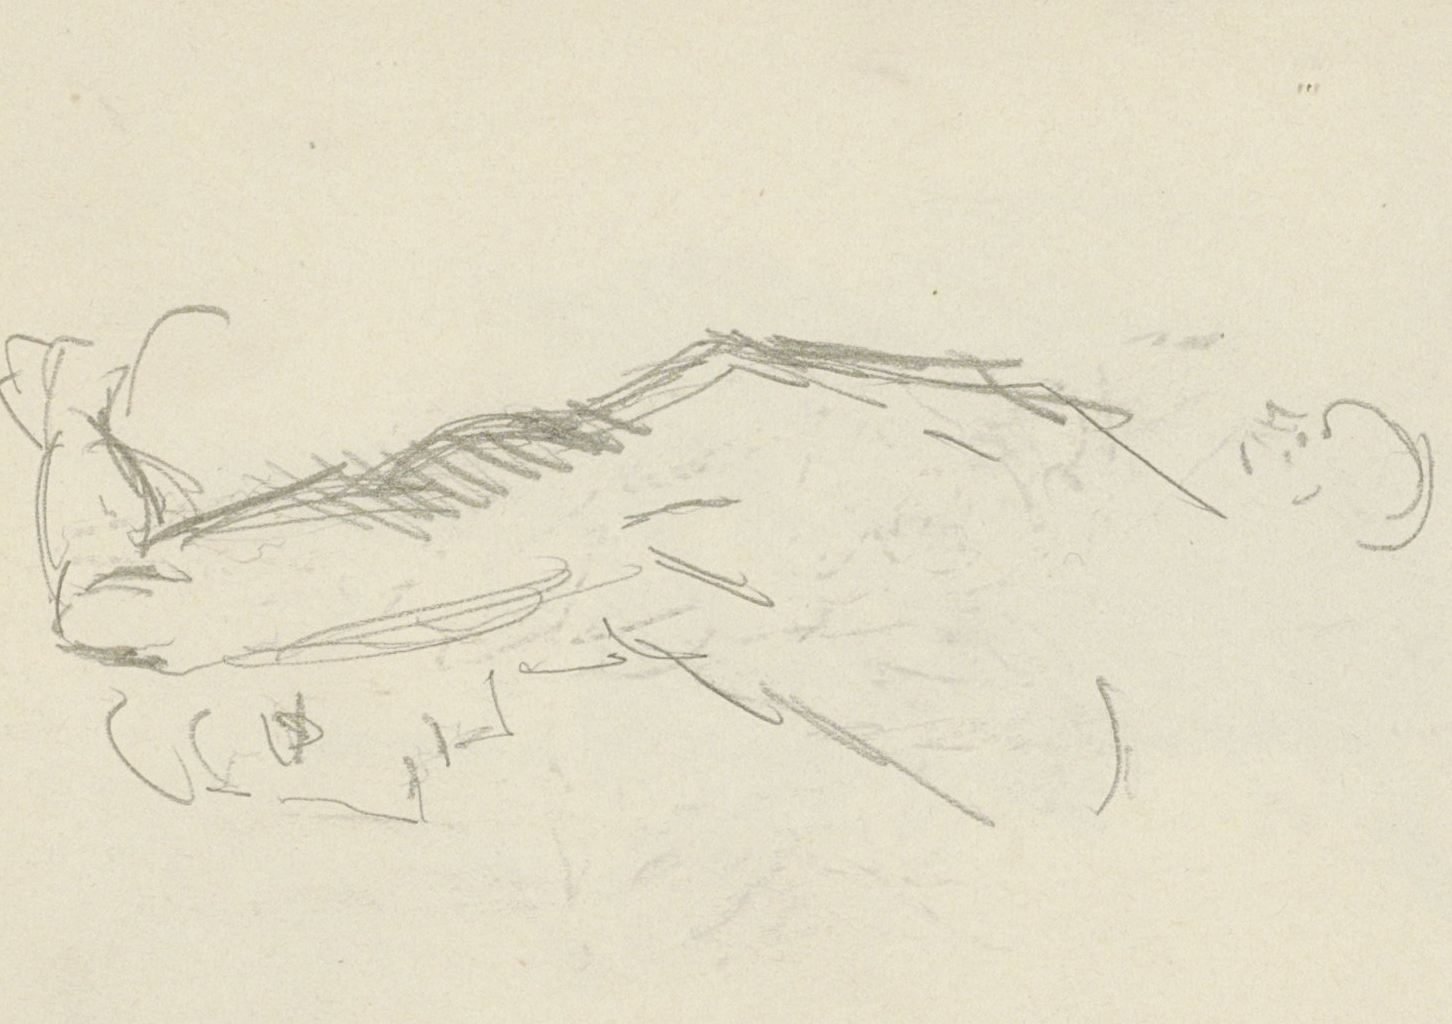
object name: sketchbook leaf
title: Vrouwelijk naakt met haar armen boven haar hoofd, in profiel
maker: isaac israels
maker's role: draughtsman, painter, print maker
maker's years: 1865-1934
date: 1930-1934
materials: paper, pencil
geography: the hague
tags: arm raised upward, the (nude) human figure; 'corpo humano' (ripa) - aa - female human figure (+ sideview, profile)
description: Pagina 30 uit schetsboek XXXVIII met 45 pagina's.